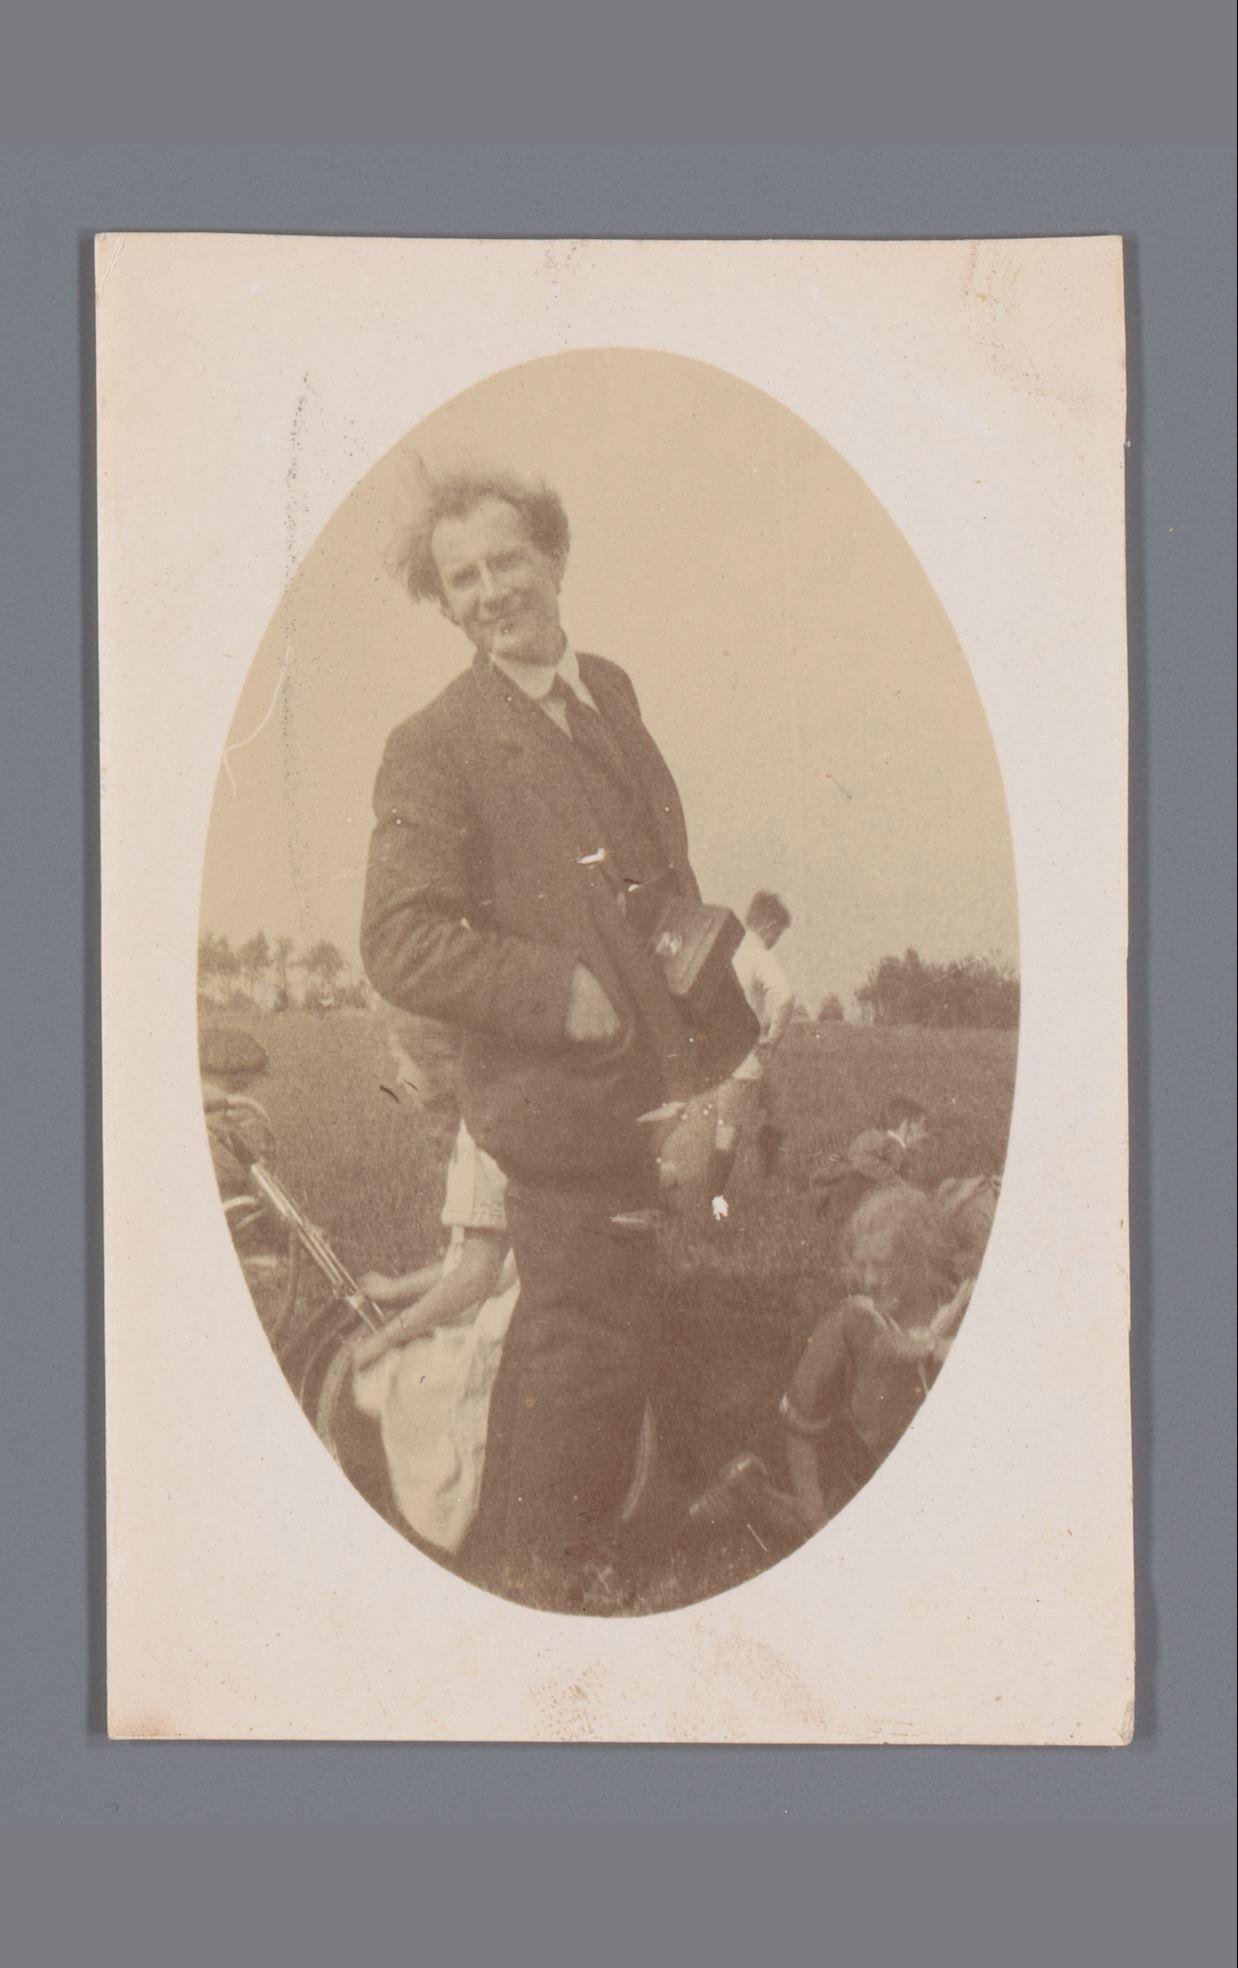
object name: photograph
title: Portret van een onbekende man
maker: Anonymous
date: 1880-1940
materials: photographic support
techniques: gelatin silver print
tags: historical persons